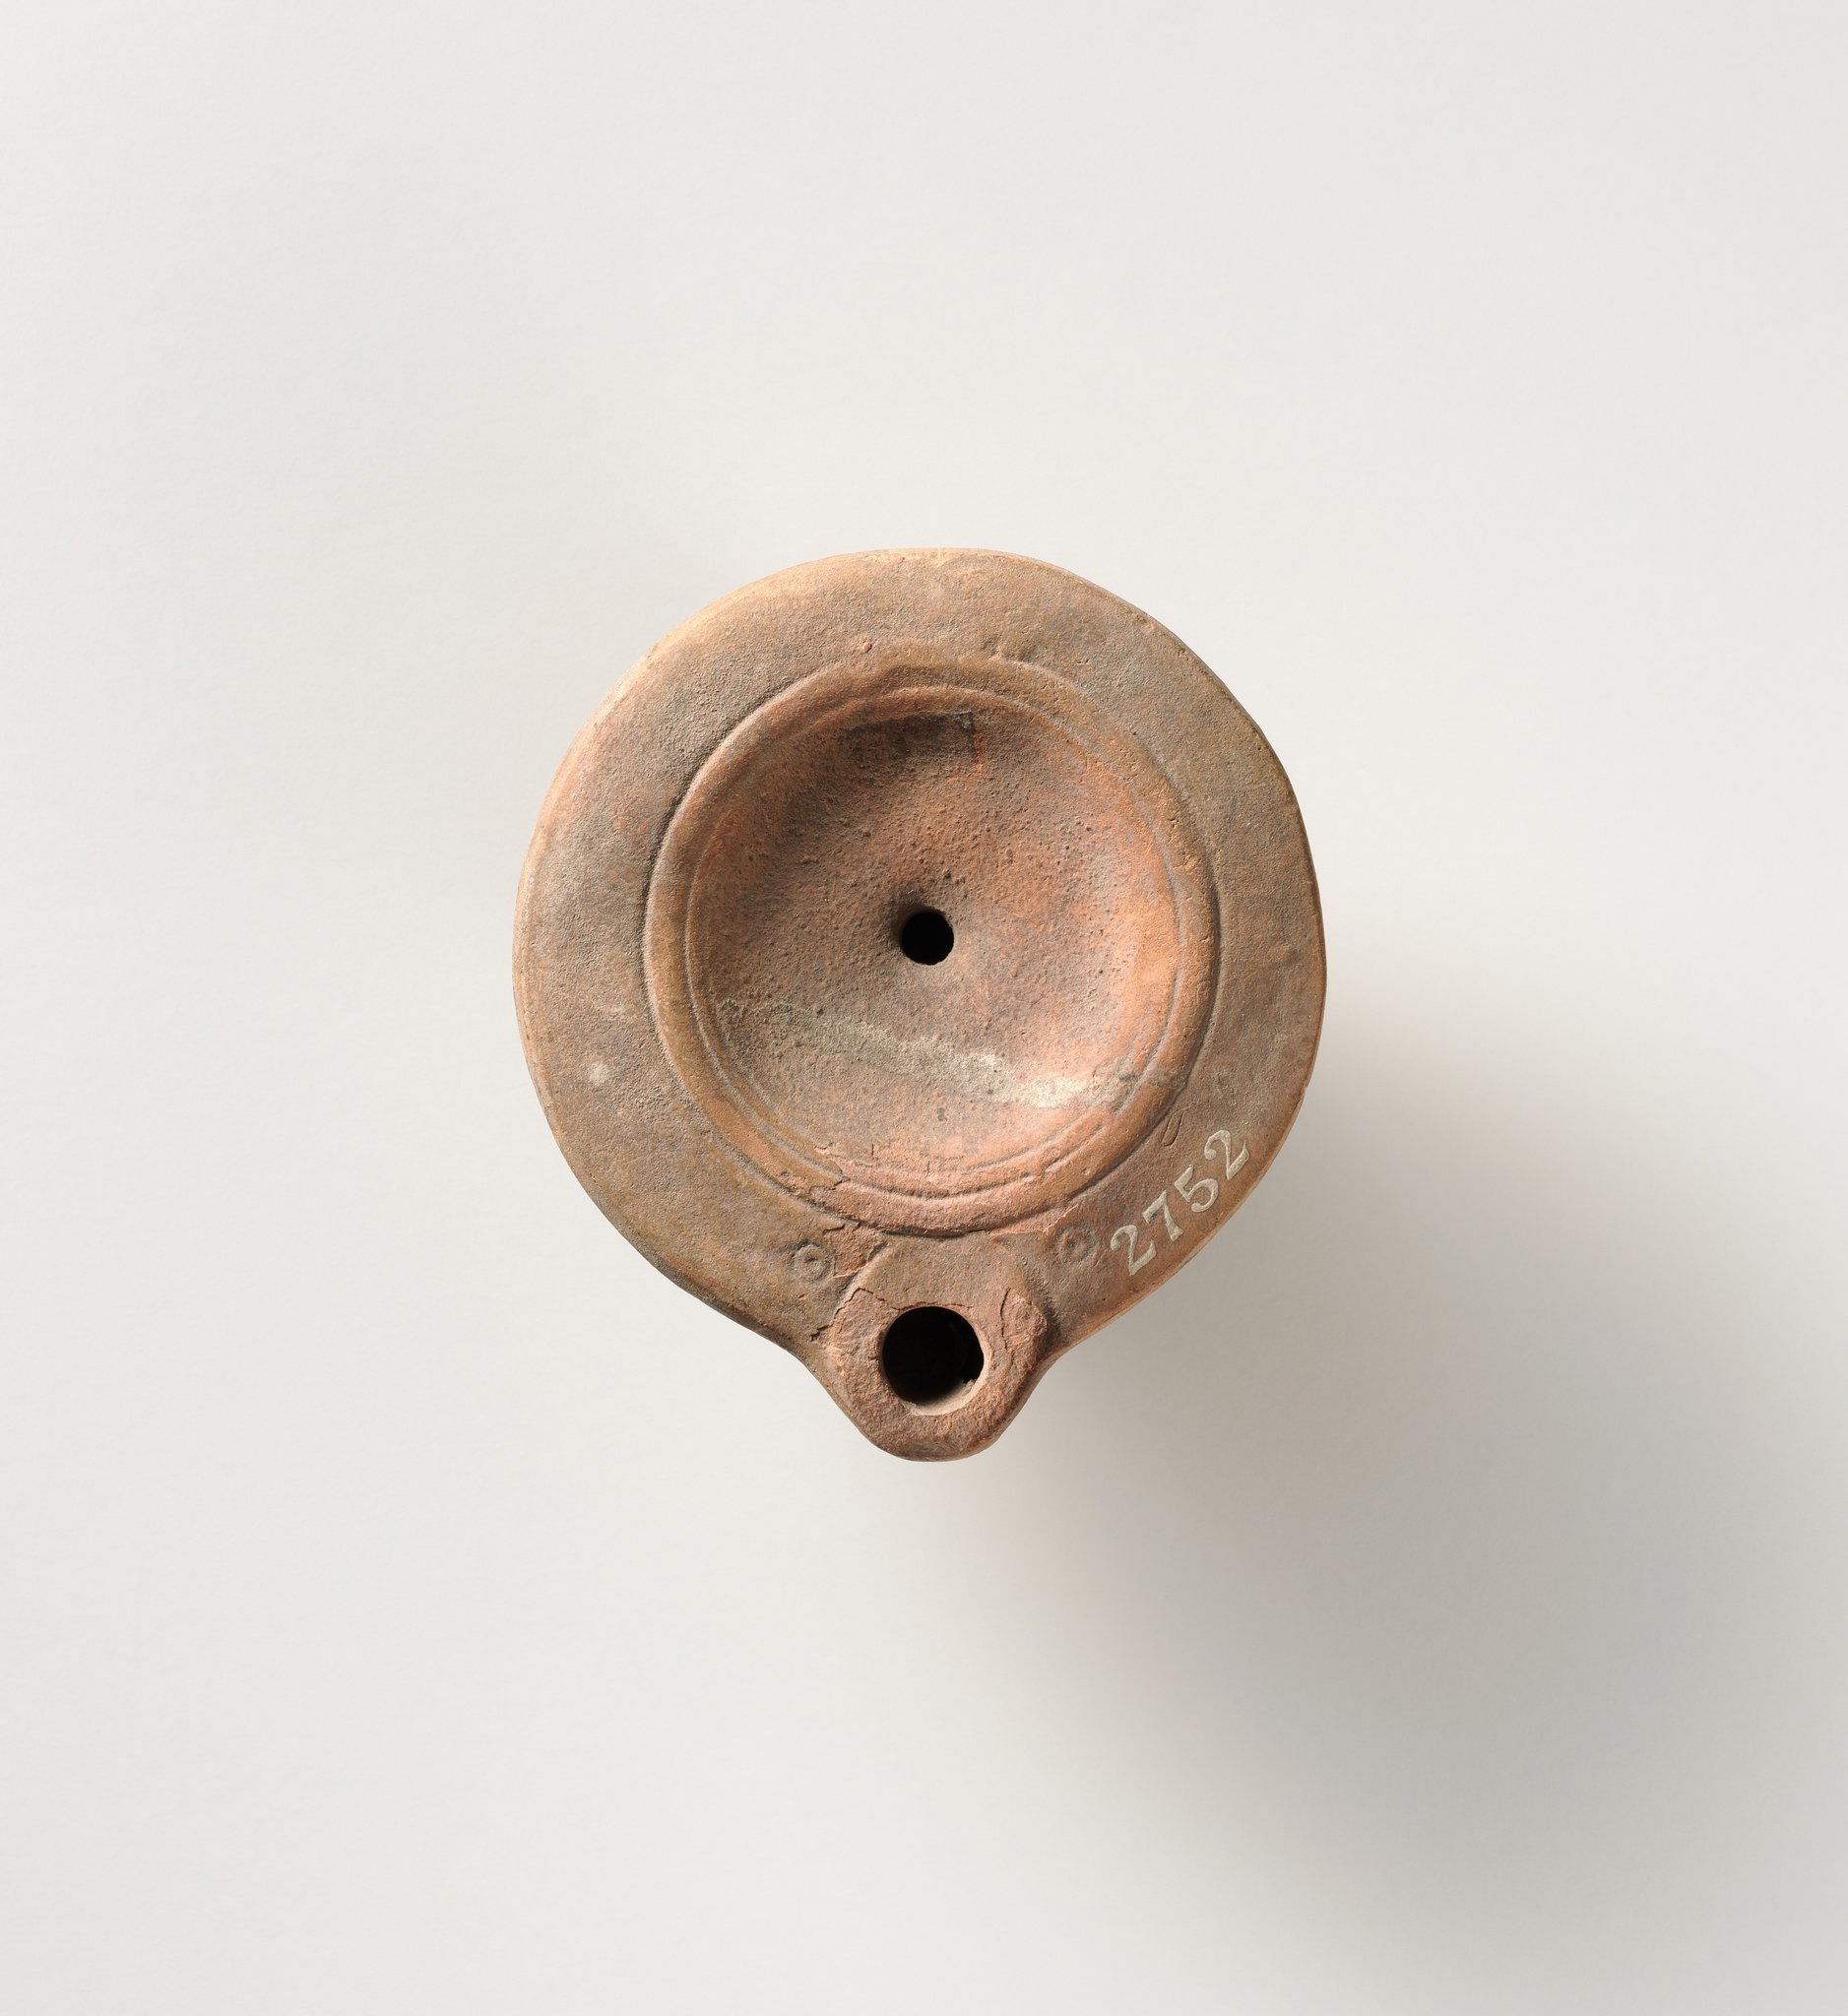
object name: lamp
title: Terracotta oil lamp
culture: roman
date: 101-200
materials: terracotta